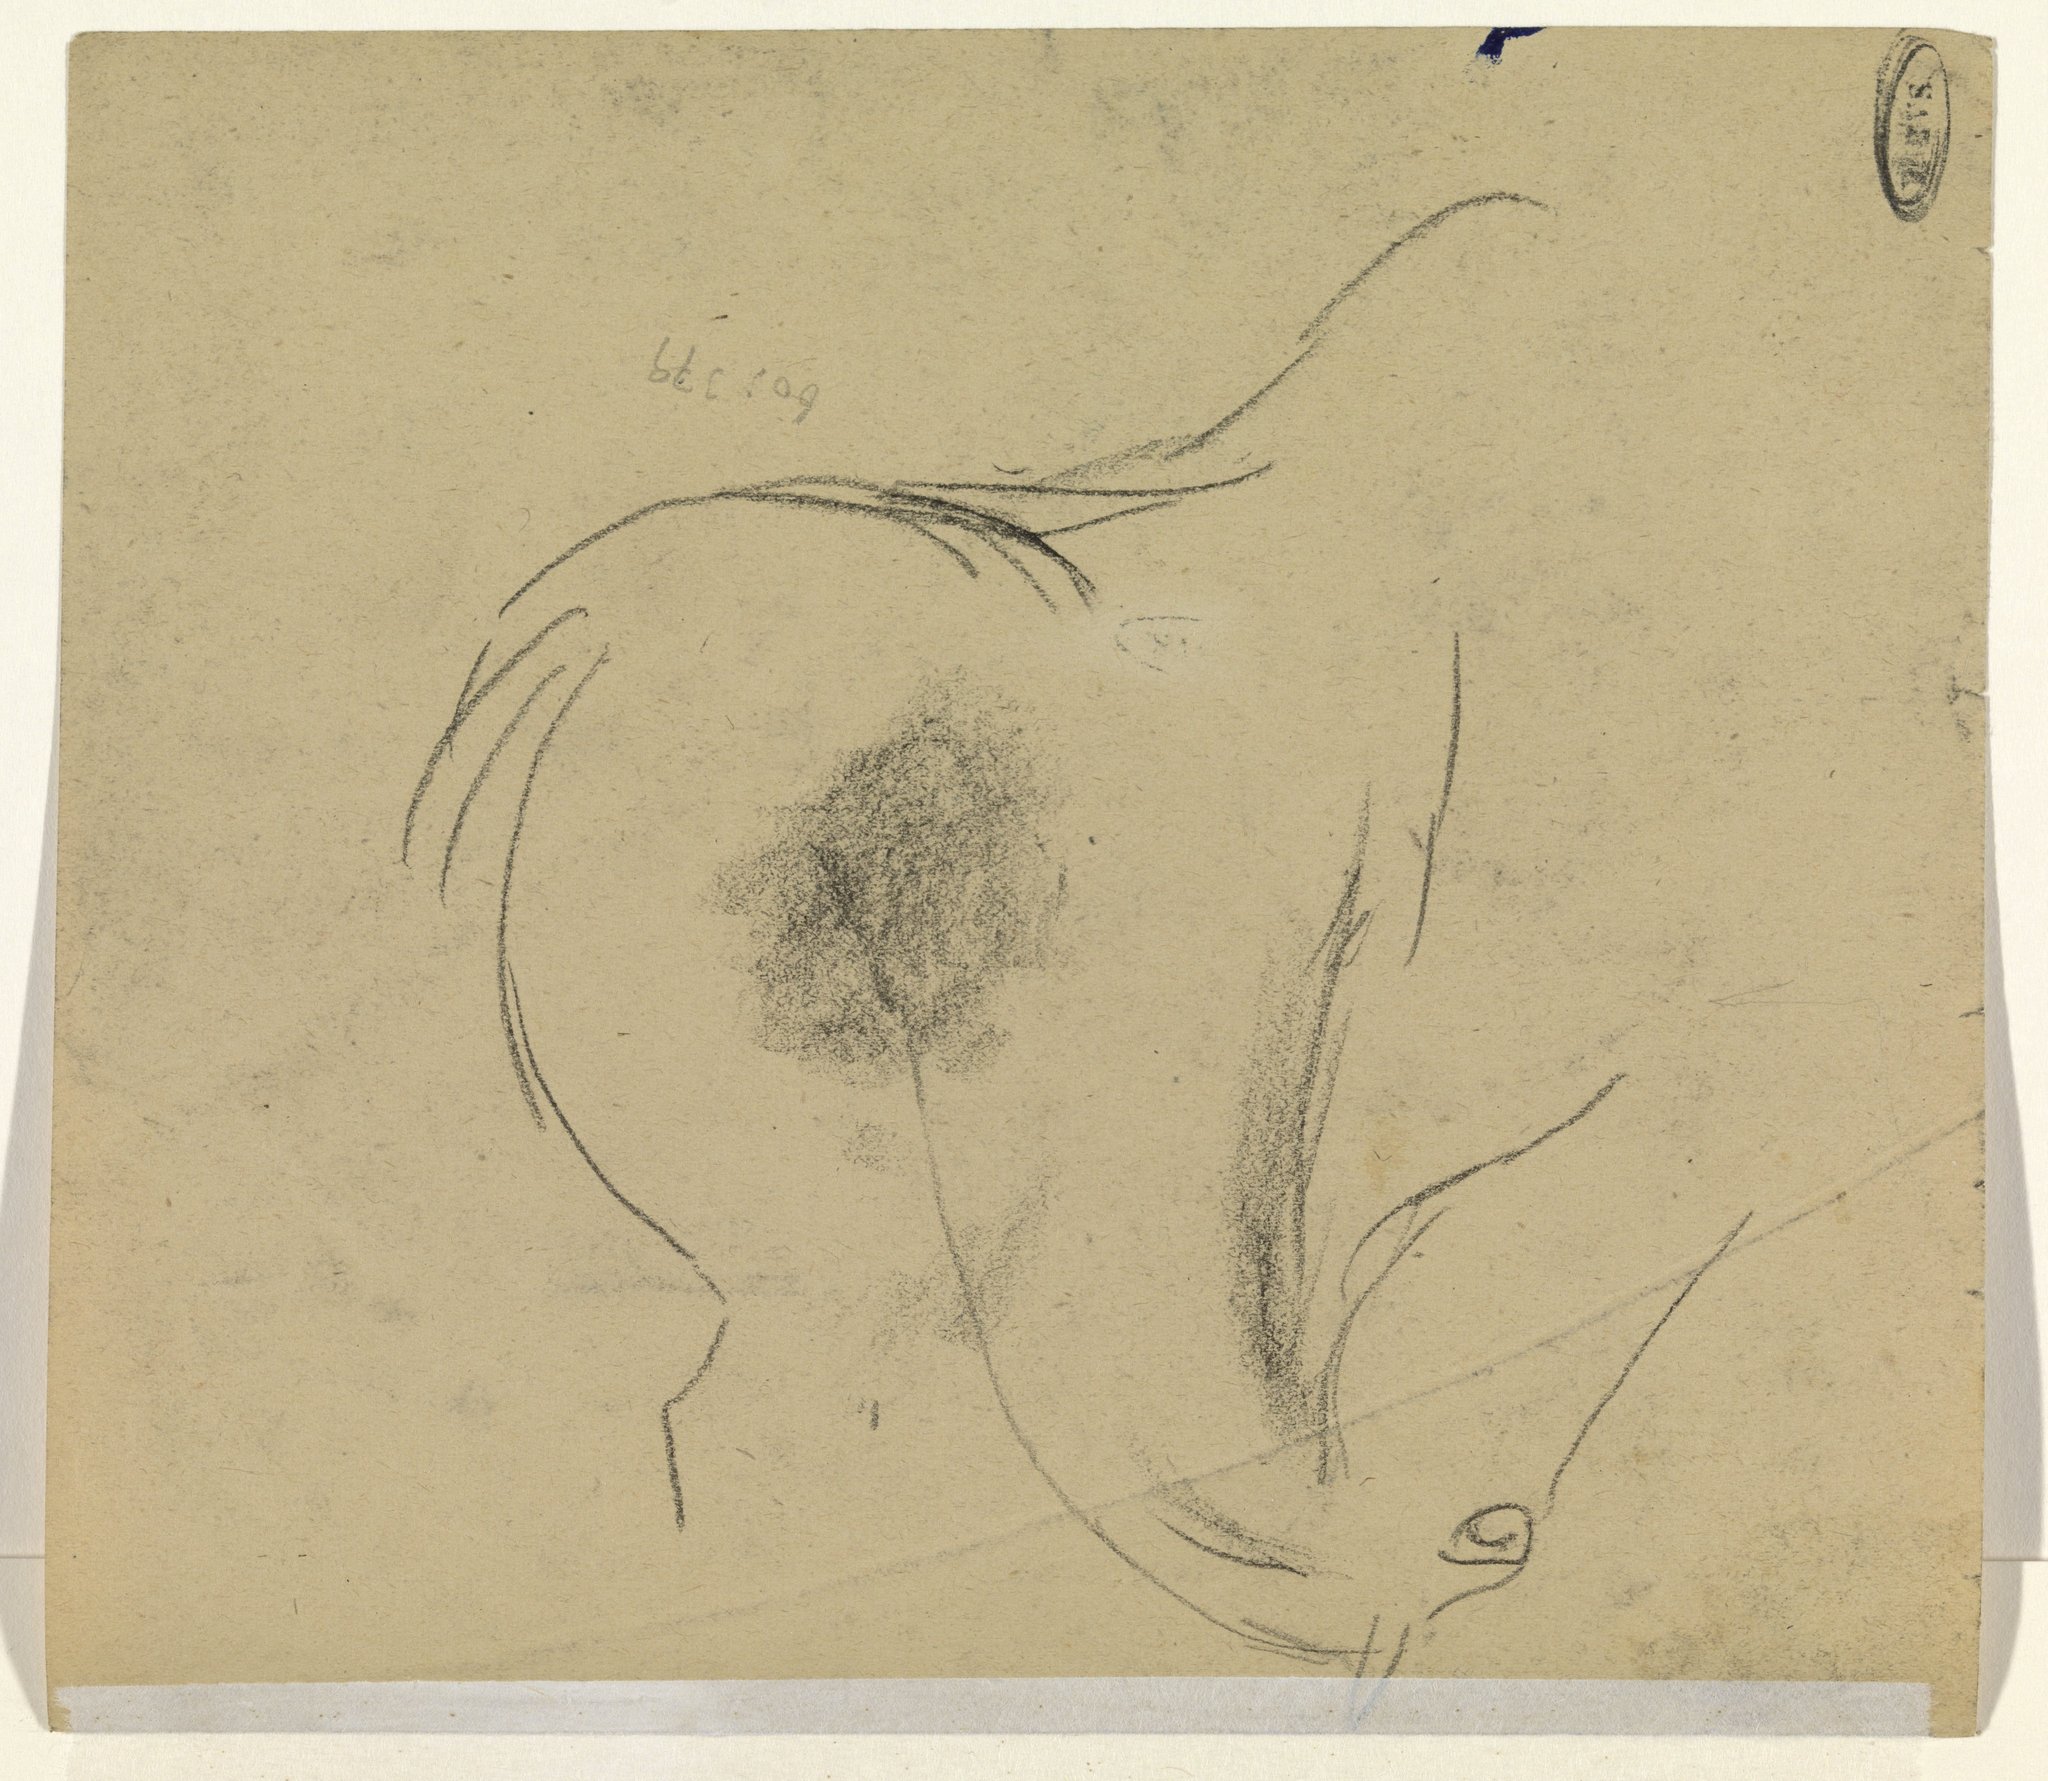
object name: drawing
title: Paardenhoofd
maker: leo gestel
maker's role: draughtsman, print maker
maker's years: 1881-1941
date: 1891-1941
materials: chalk, paper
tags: horse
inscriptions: collector's mark: Lugt 2228